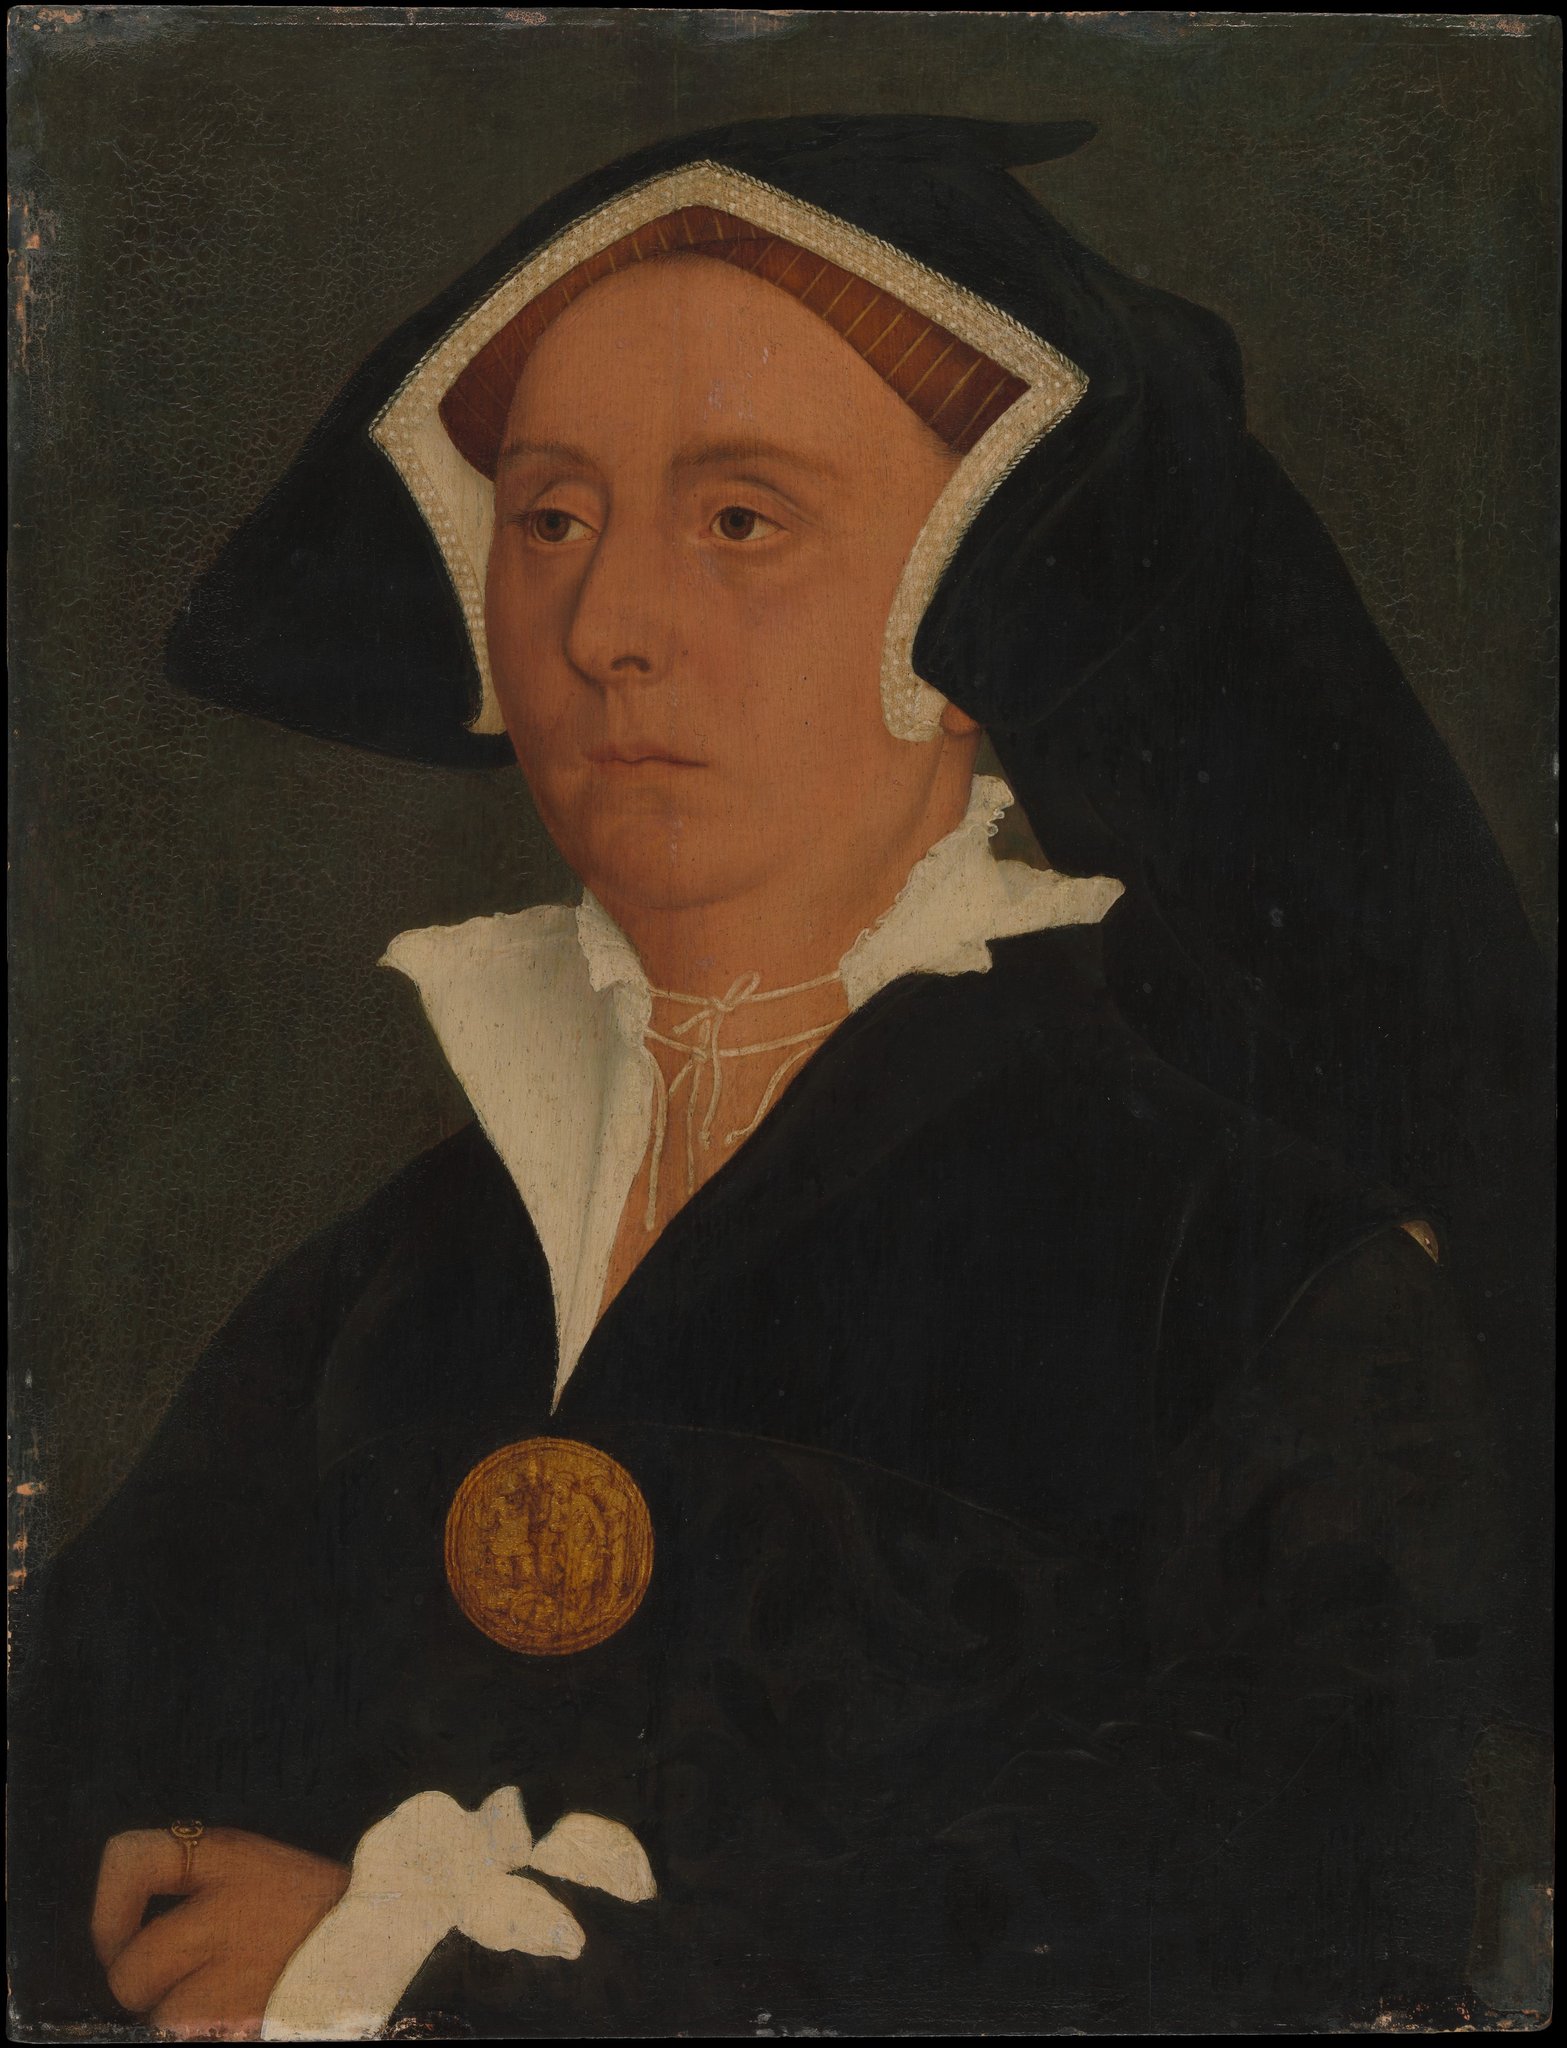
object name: painting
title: Lady Rich (Elizabeth Jenks, died 1558)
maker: hans holbein the younger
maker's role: artist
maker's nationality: german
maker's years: 1497-1543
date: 1540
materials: gold, wood, oil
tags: portraits,women